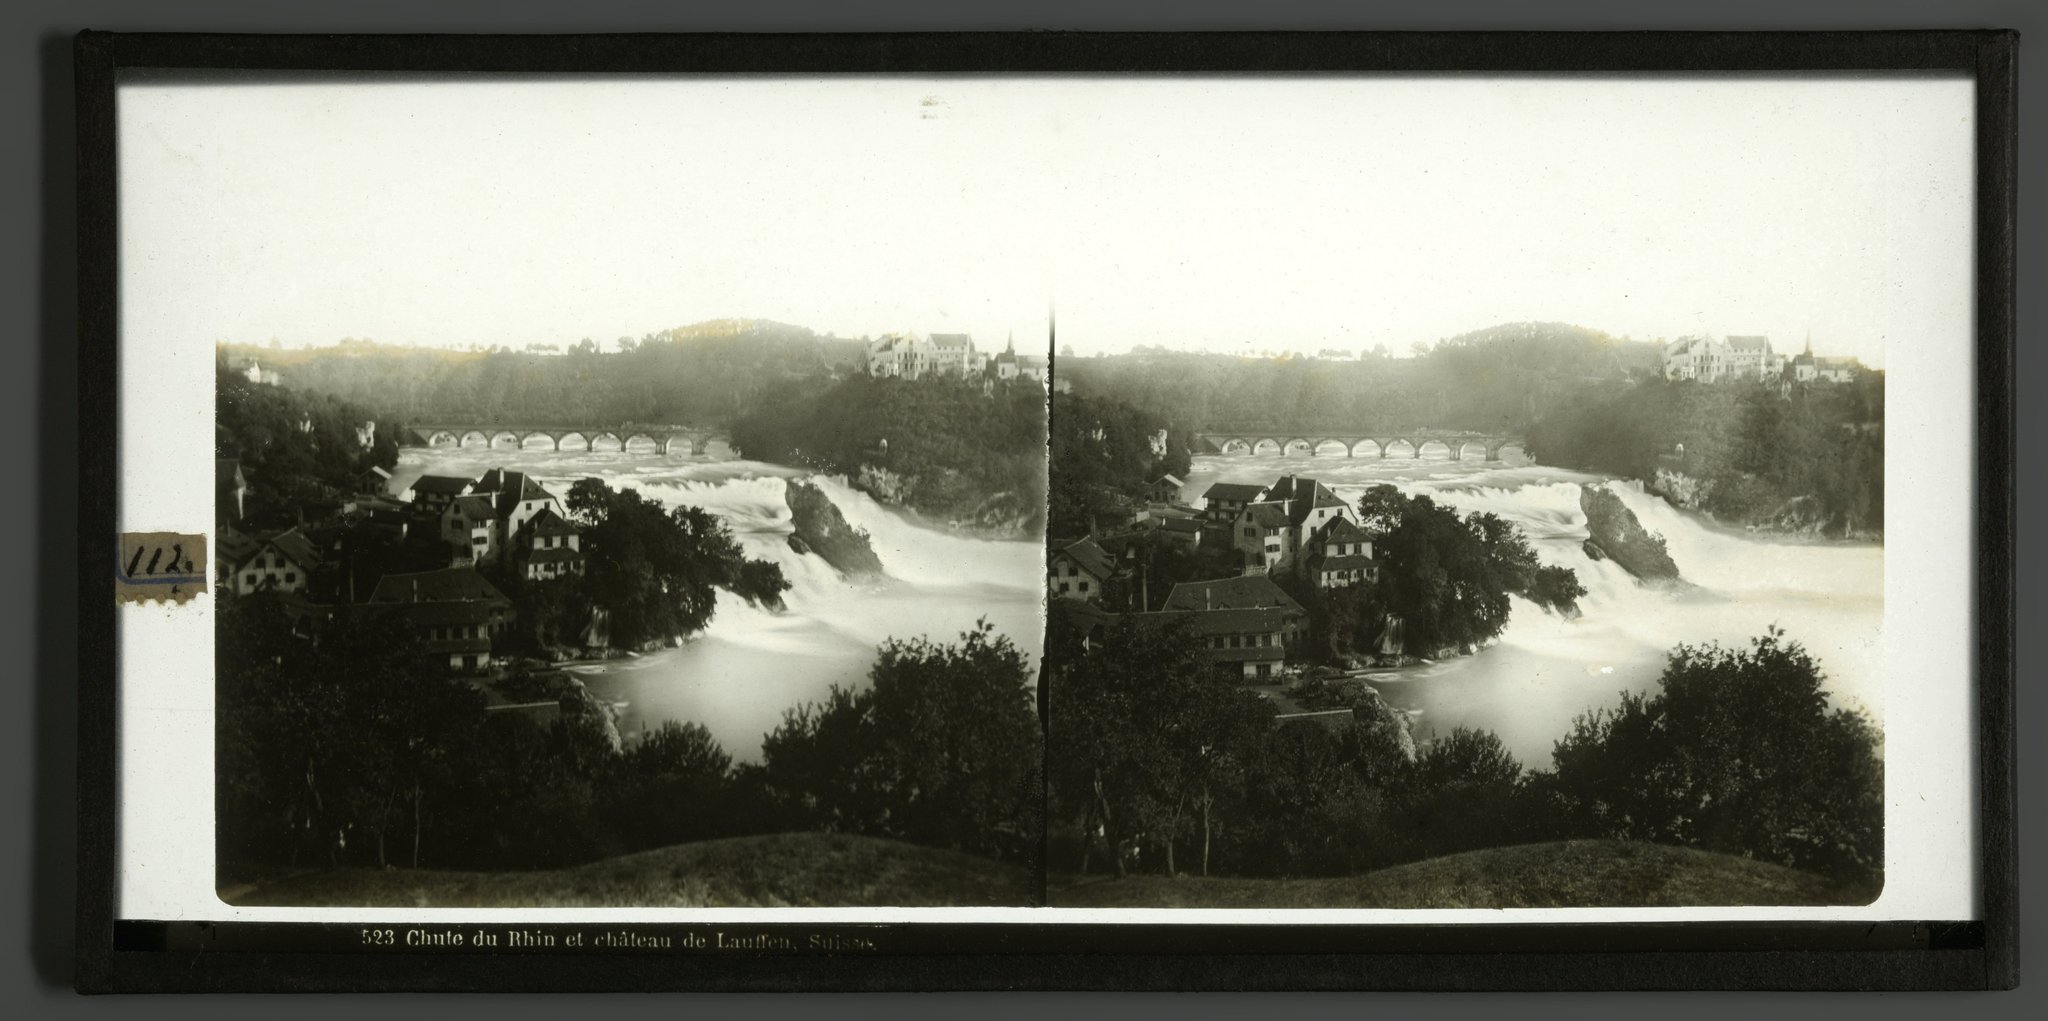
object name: stereoscopic photograph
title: Gezicht op de Rheinfall en het kasteel Laufen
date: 1860-1870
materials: glass, paper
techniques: slide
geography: neuhausem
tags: waterfall, landscape with tower or castle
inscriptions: inscription: ‘523 Chute du Rhin et chateau de Lauffen, Suisse’, number: ‘112’